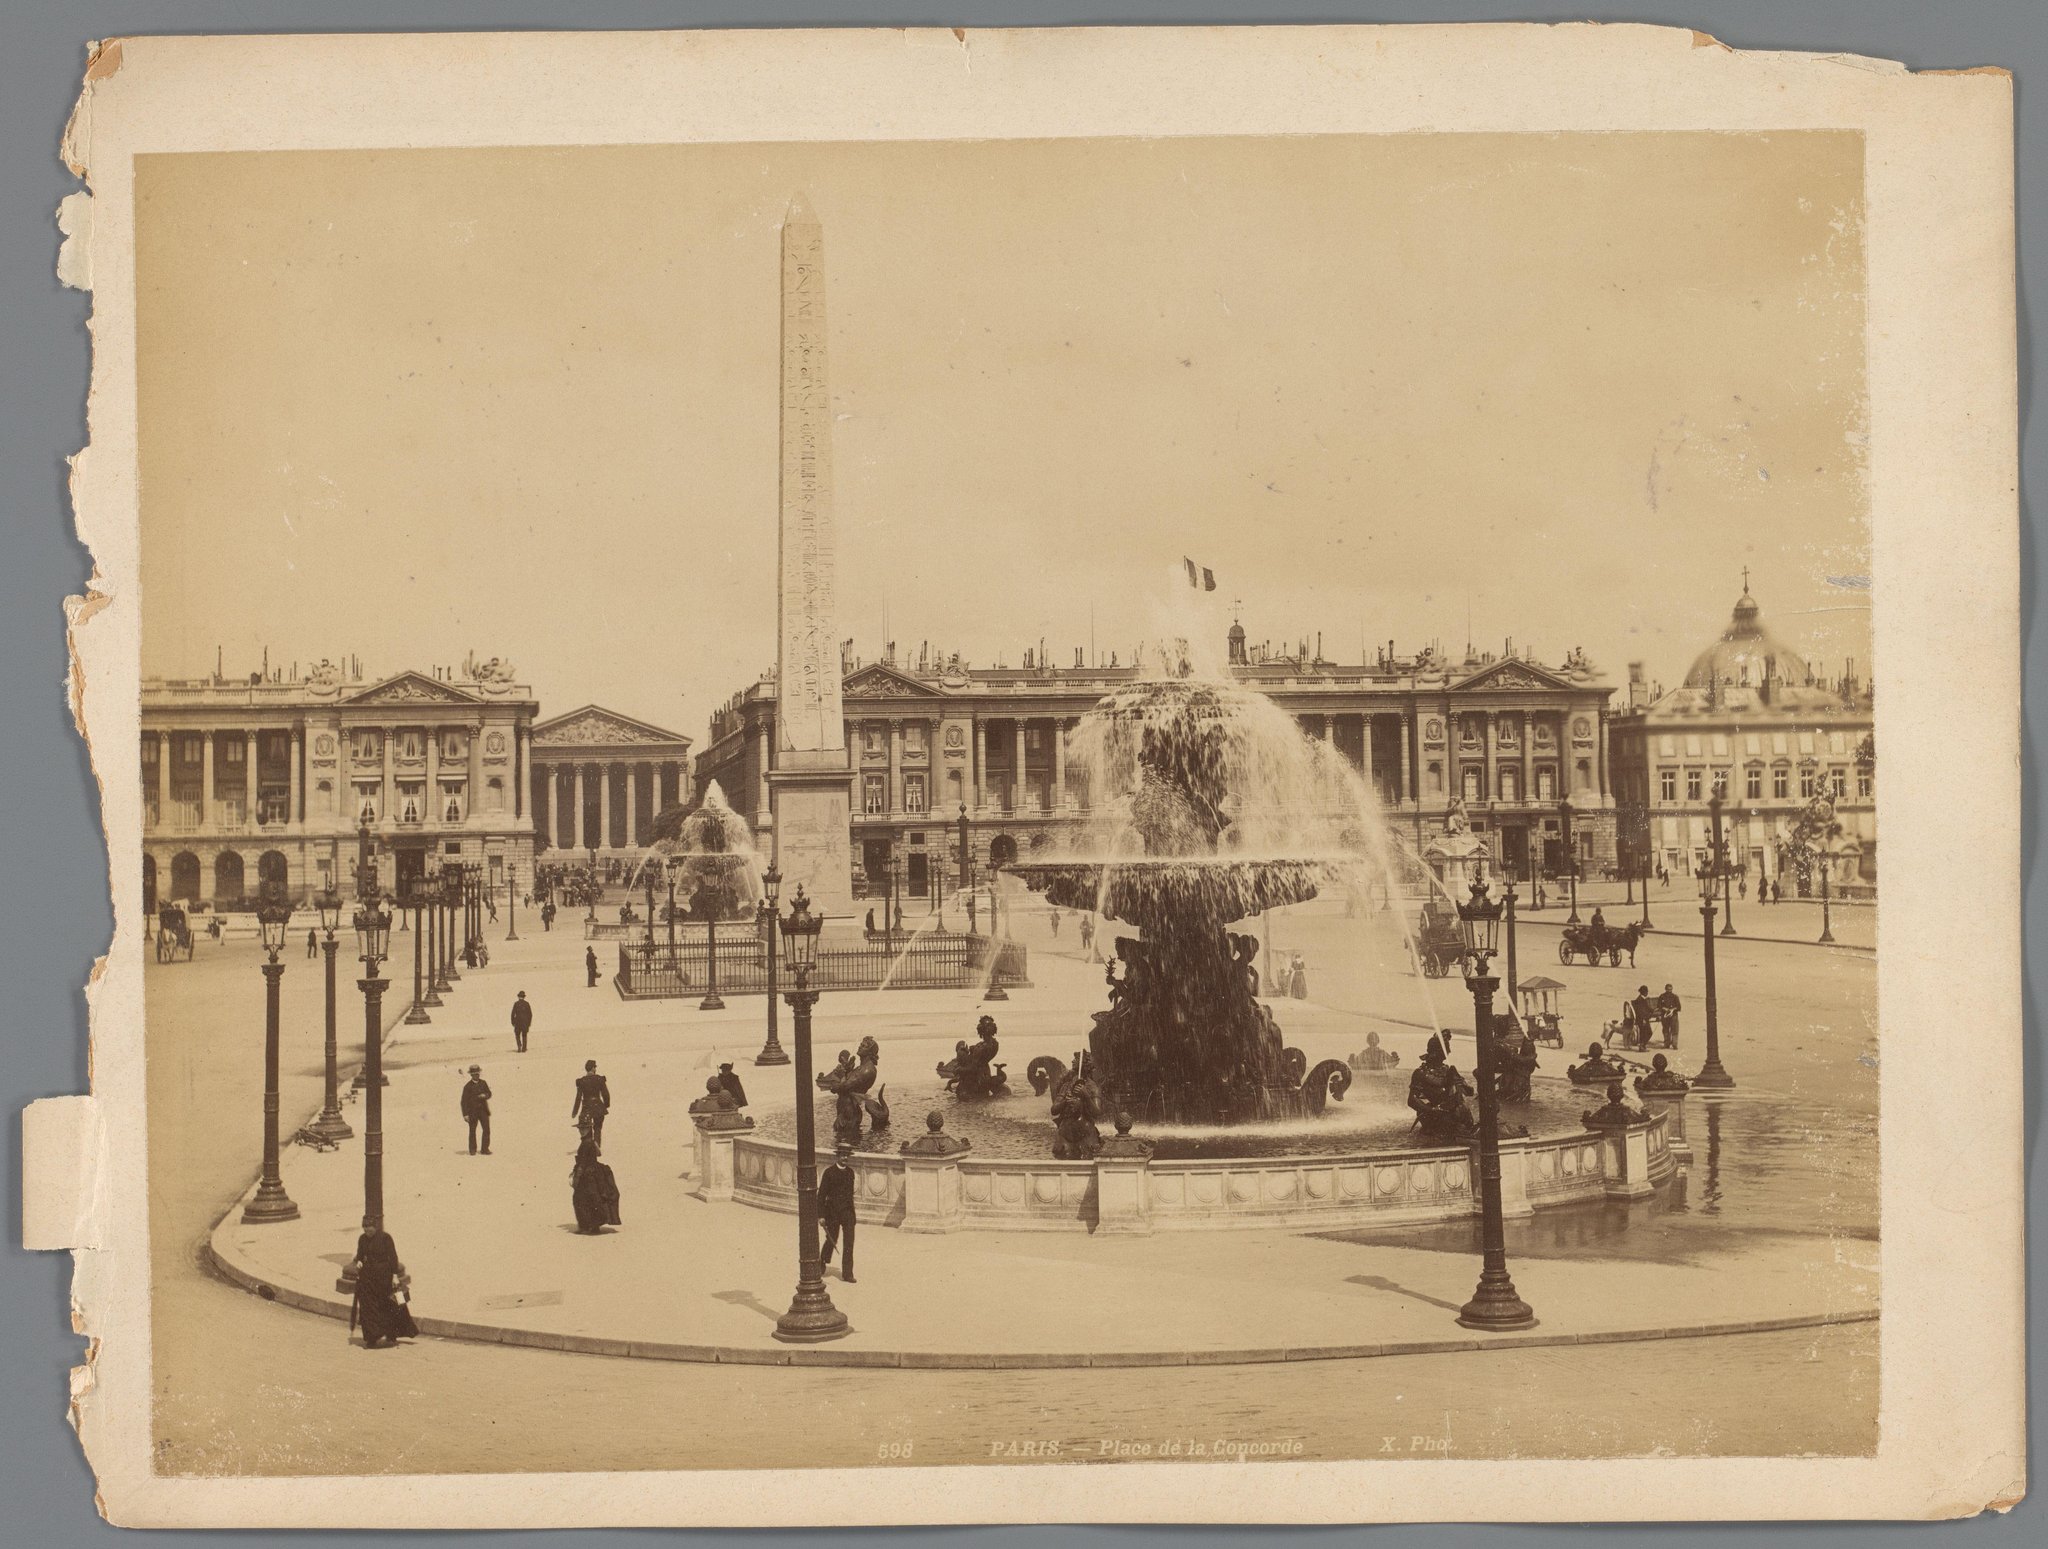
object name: photograph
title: Place de la Concorde in Parijs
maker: martinet (uitgever)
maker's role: publisher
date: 1872-1886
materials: cardboard, paper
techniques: albumen print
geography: paris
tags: square, place, circus, etc., ornamental fountain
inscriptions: number: ‘598’